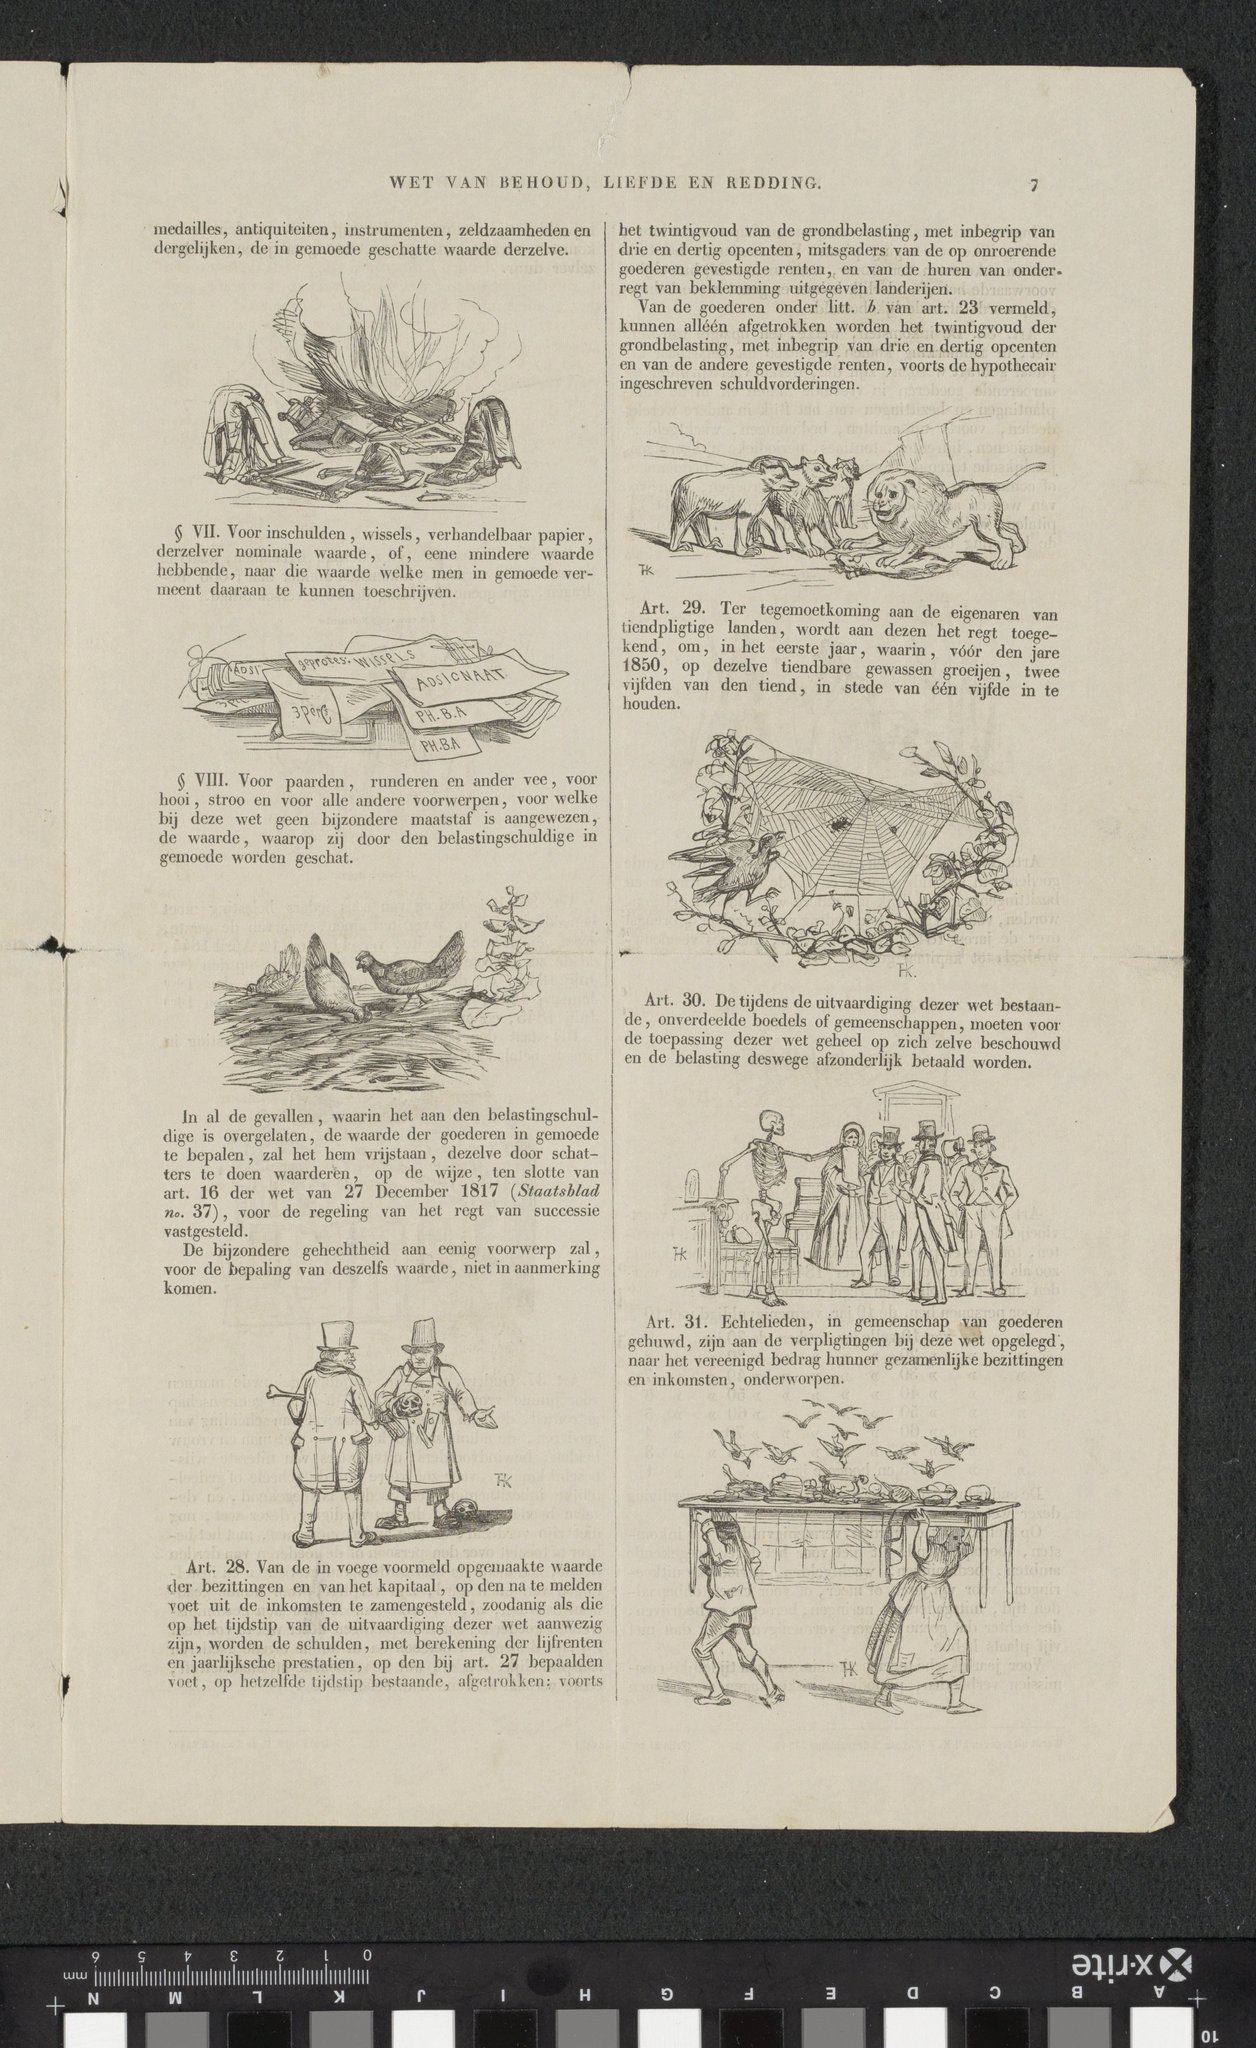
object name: print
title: Herdruk van de satire op de aansporing tot deelneming in de (zogenaamde) vrijwillige 3% geldlening van 1844 (blad 7)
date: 1844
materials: paper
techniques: letterpress printing, engraving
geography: netherlands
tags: amsterdam, the hague, floris adriaan van hall, organization of trade and finance, taxes and financial administration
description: Bladzijde 7 met artikels 28-31 van het 'Vermeerderd, Verbeterd en de Volmaaktheid Overtreffend Nieuw Ontwerp van Wet van Behoud, Liefde en Redding'. Een enigszins aaangepaste herdruk van satire in zestien bladzijden op de aansporing tot deelneming in de (zogenaamde) vrijwillige 3% geldlening uitgeschreven in maart 1844 door minister F.A. van Hall. Binnenzijde van een dubbelgevouwen blad bedrukt op alle zijden.